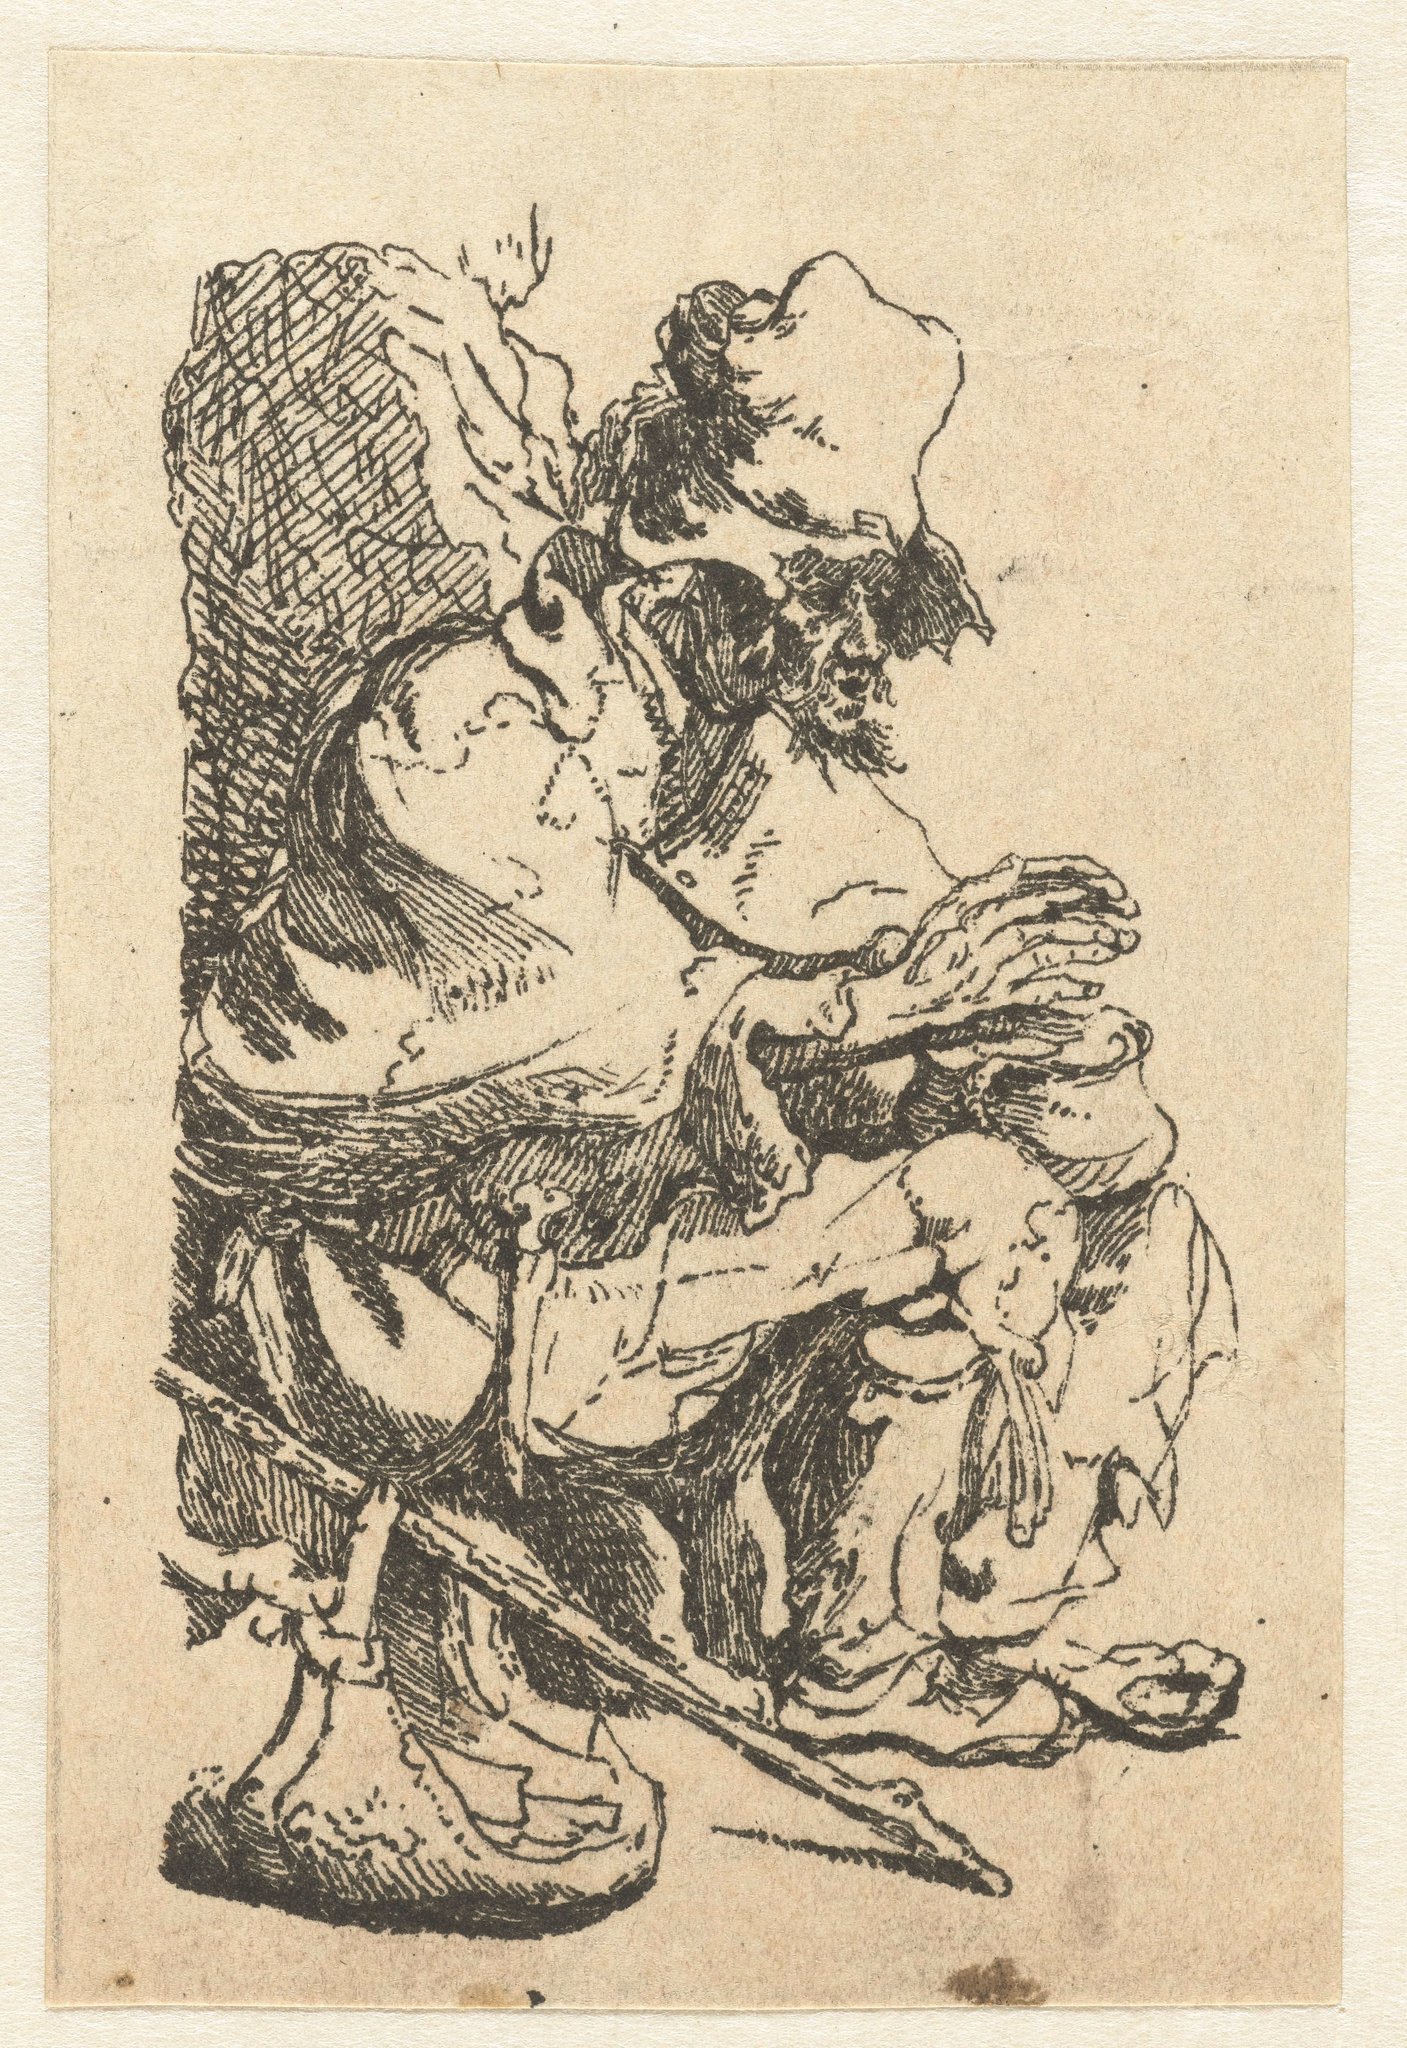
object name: print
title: Beggar seated warming his hands at a chafing dish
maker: Anonymous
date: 1719-1780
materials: paper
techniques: lithograph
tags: beggar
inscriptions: collector's mark: Lugt 2228, collector's mark: Lugt 2760, collector's mark: ‘18’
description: Prent afgesneden van een blad met zes kopieën naar gelijknamige prenten van Rembrandt, naar voorbeeld van kopieën van Vivaris.